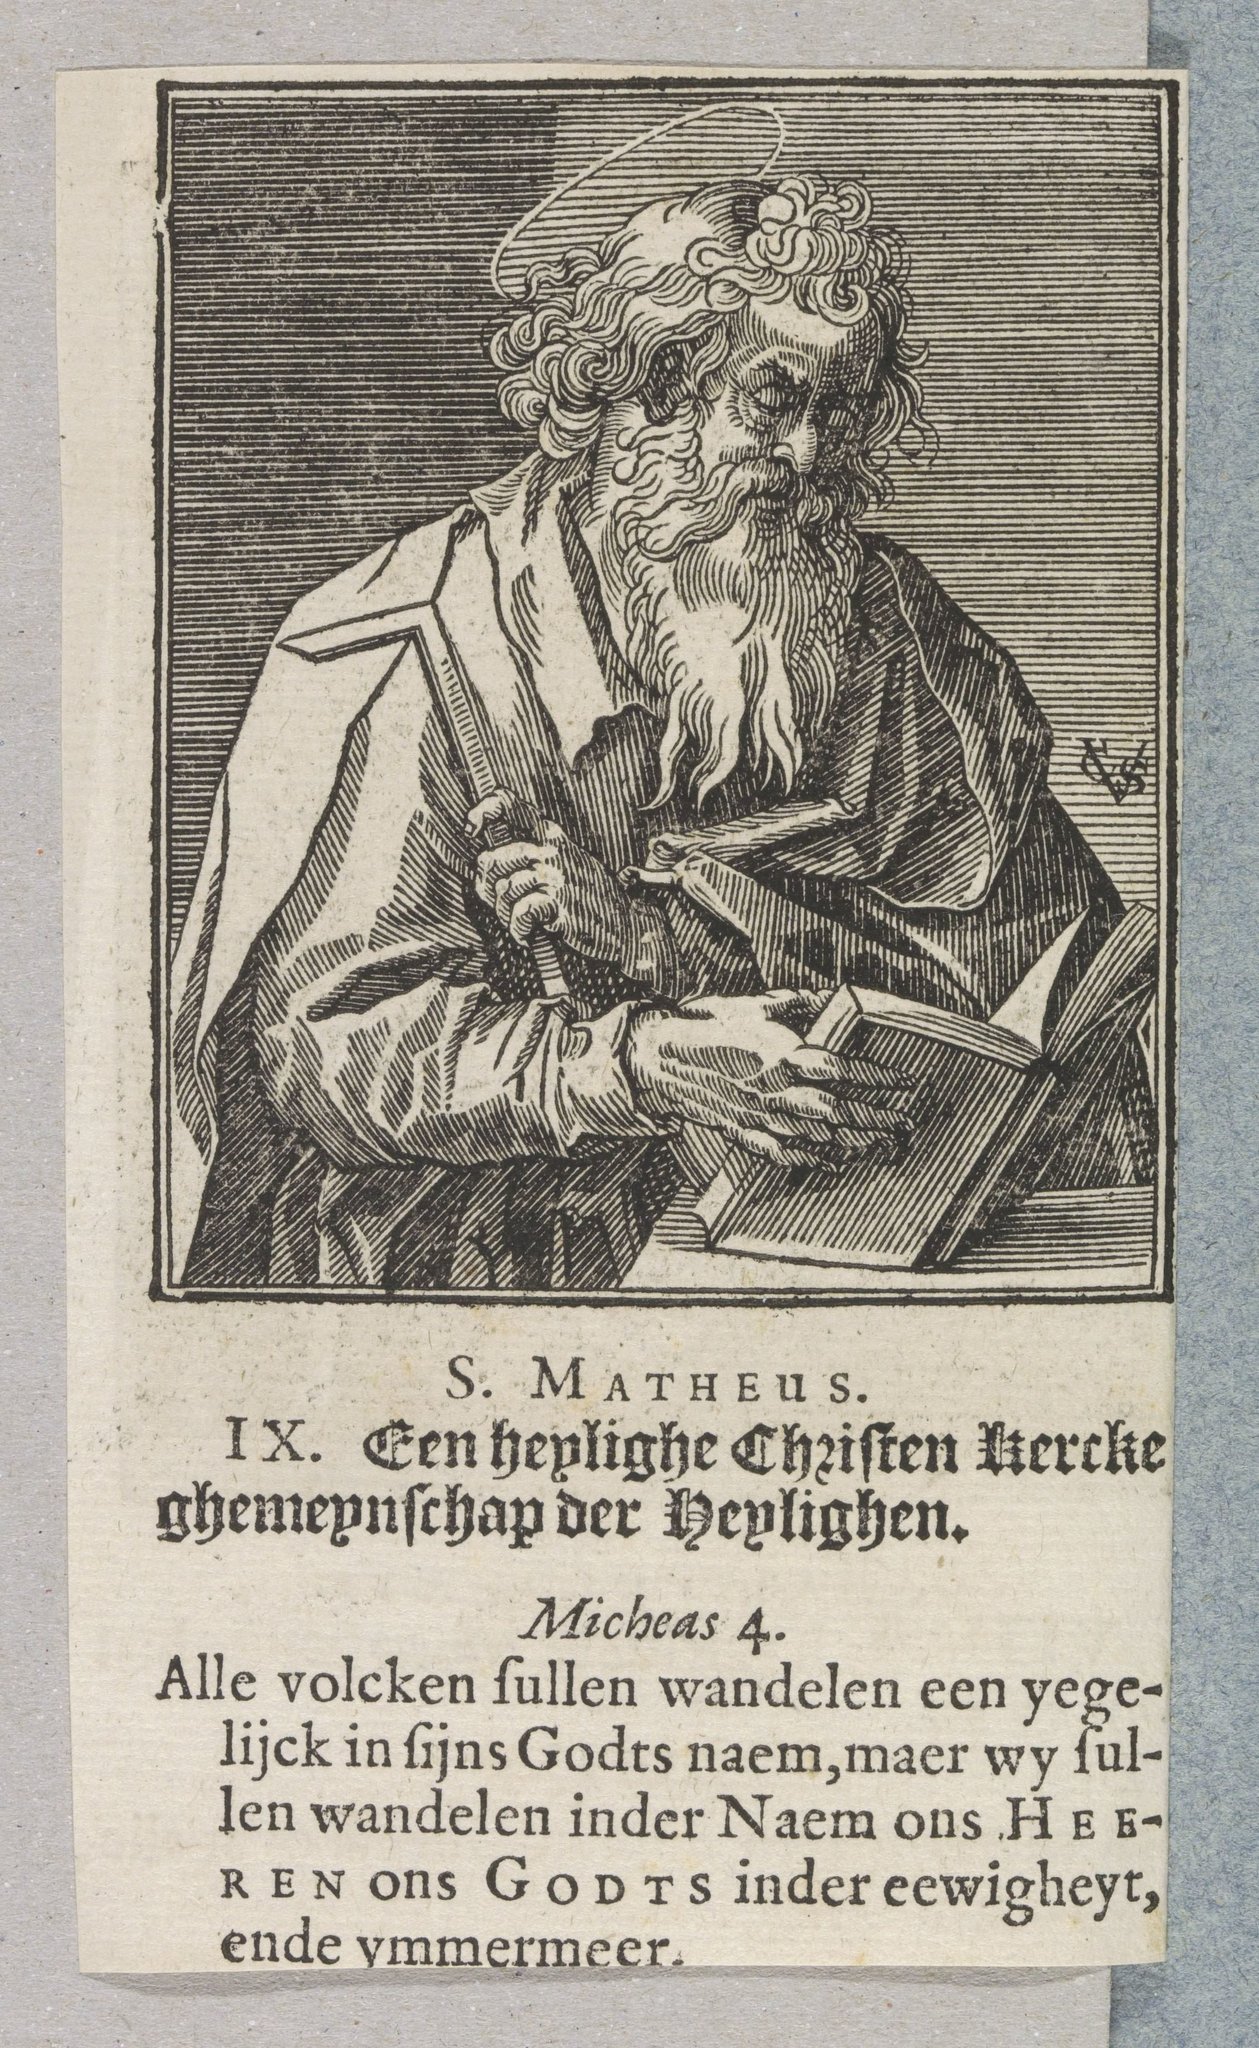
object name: book illustration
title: S. Matheus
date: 1629-1646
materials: paper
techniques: letterpress printing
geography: amsterdam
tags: the apostle and evangelist matthew (mattheus); possible attributes: angel, axe, book, halberd, pen and inkhorn, purse, scroll, square, sword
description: De prent is afkomstig uit een van de uitgaven van P.J. Paets uit Amsterdam. De prent wordt mogelijkj al gebruikt in: Der Zielen Lust-hof. Leuven, I.Jacbosz voor P.J. Paets [= Amsterdam, P.J. Paets], 1629. Ze komt in ieder geval voor in: Het Nieuwe Testament ons Salichmaeckers Jesu Christi. Amsterdam, P.J. Paets, 1646. De voorstelling is gekopieerd naar een prent van Johann I Sadeler naar Maerten de Vos.